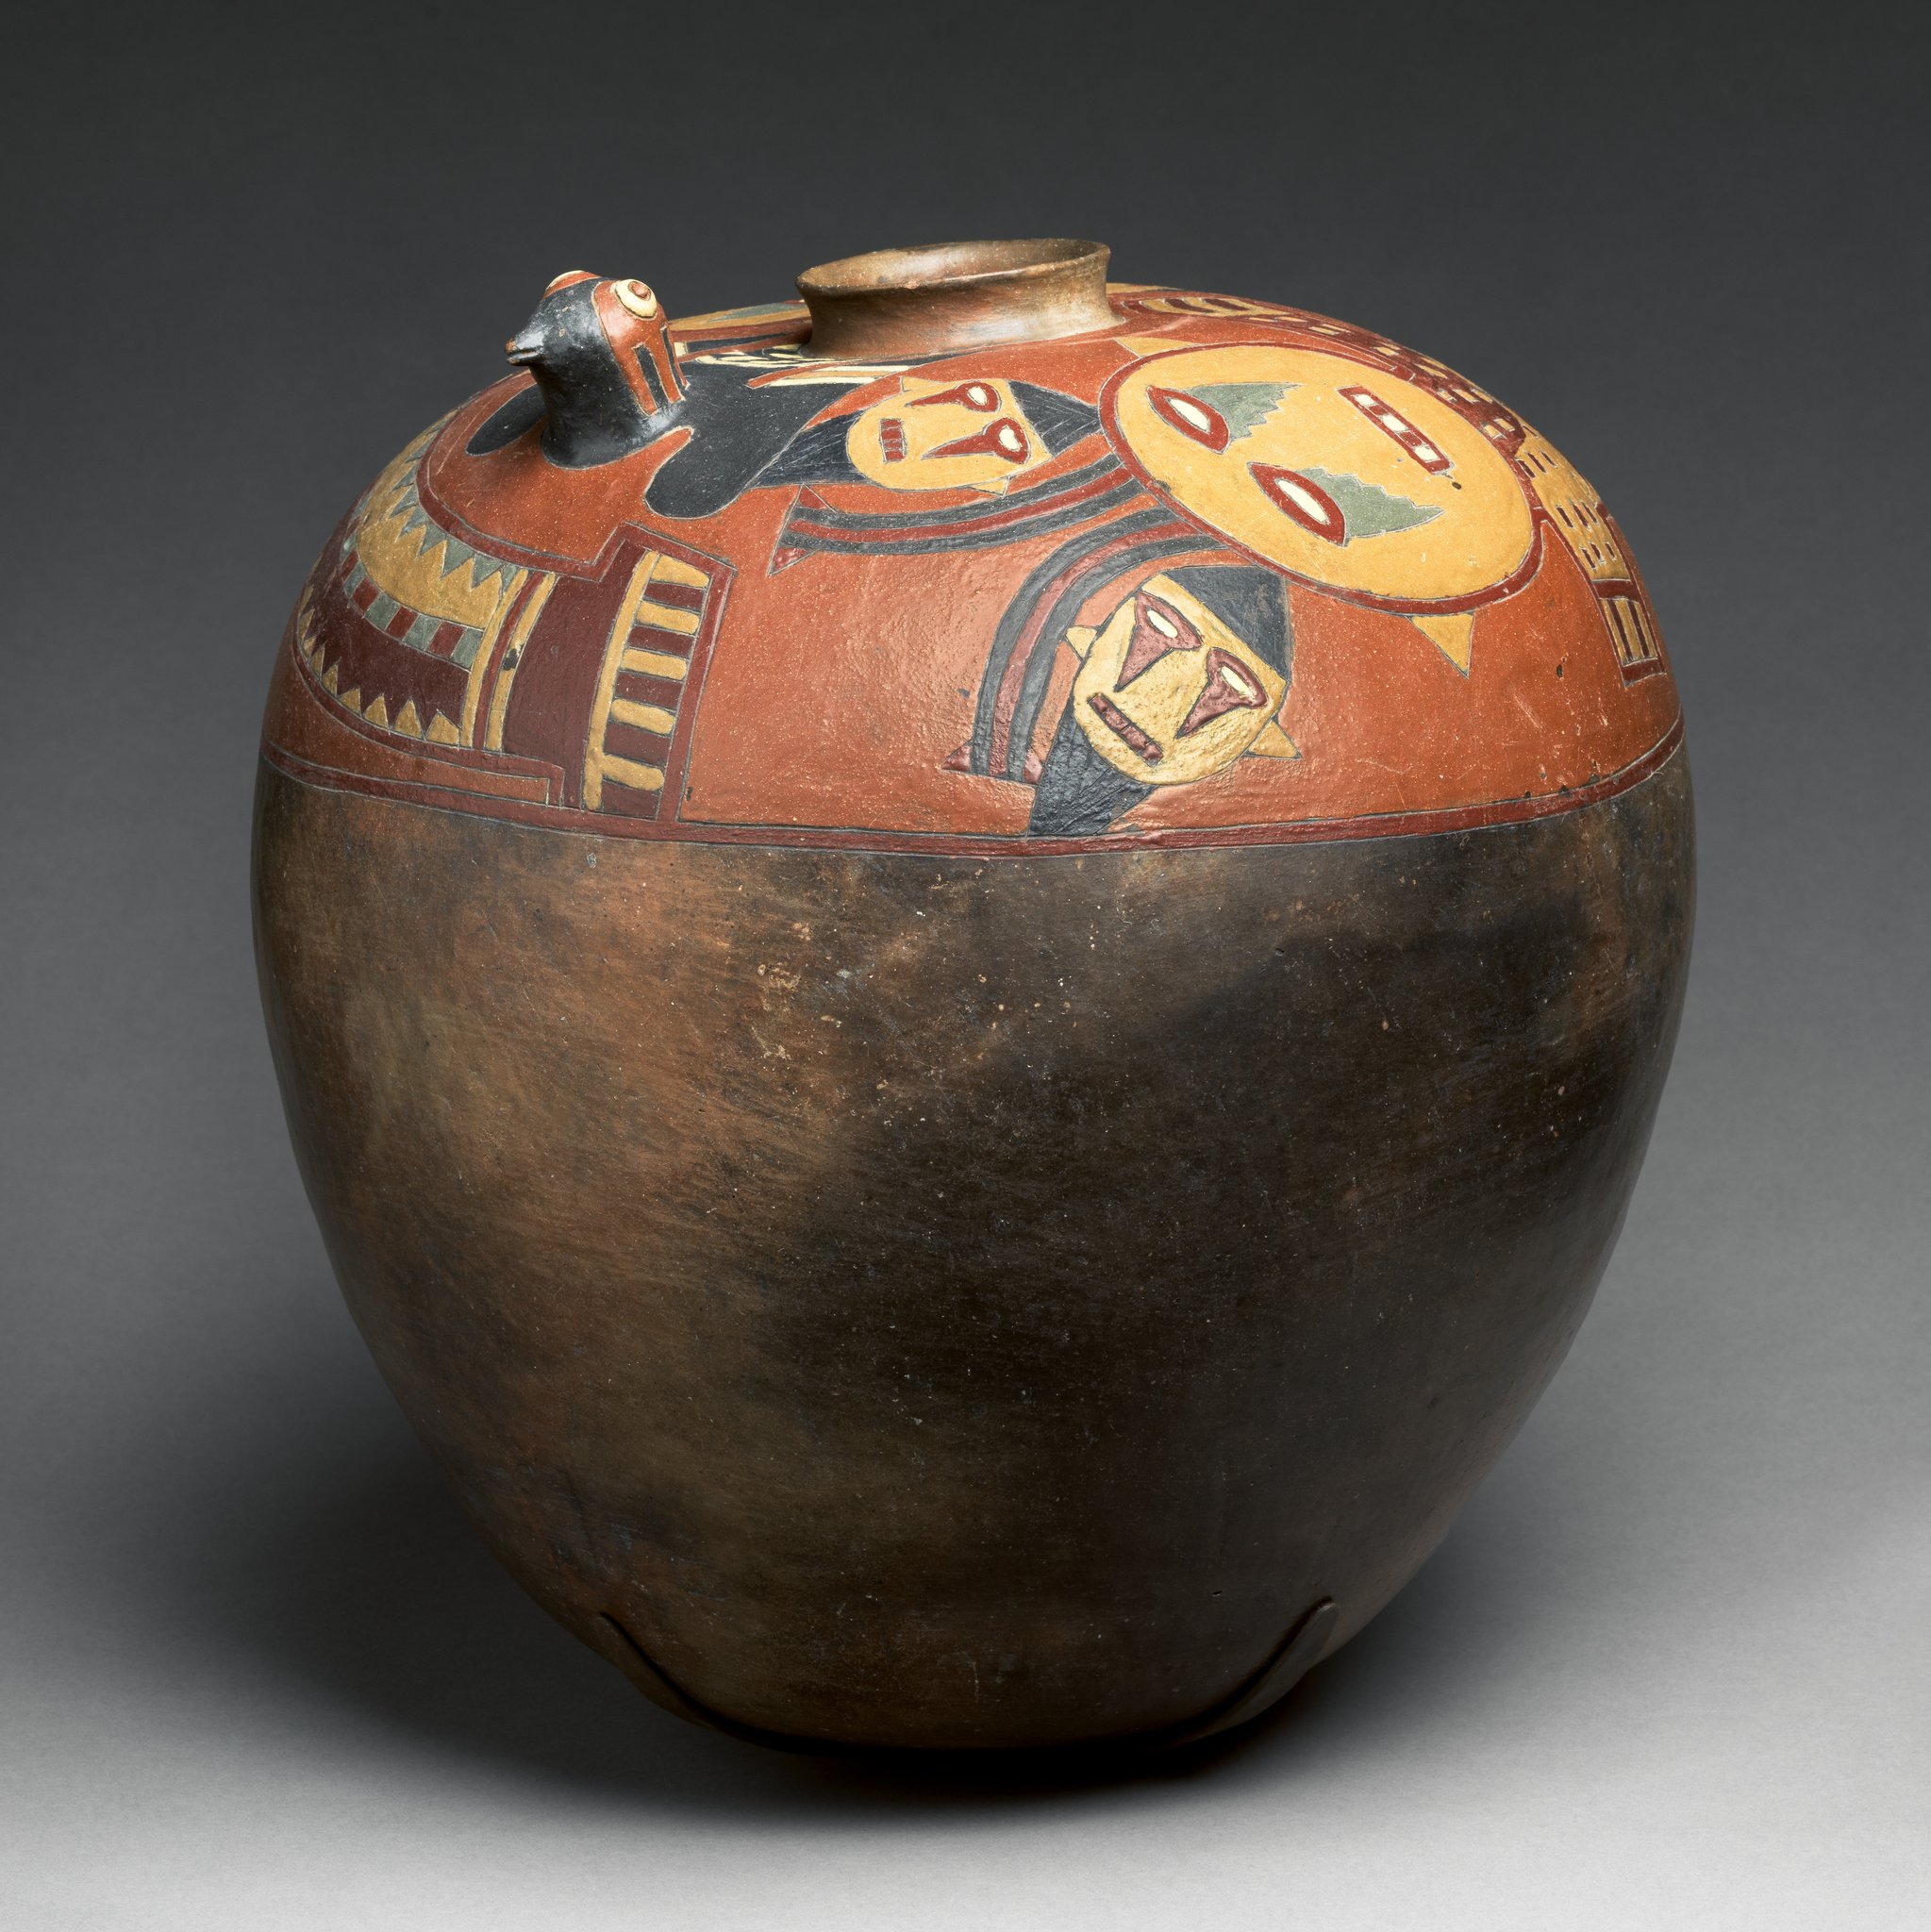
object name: jar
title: Storage jar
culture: paracas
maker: paracas artist(s)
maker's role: artist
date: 350-200 BCE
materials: ceramic, paint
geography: peru